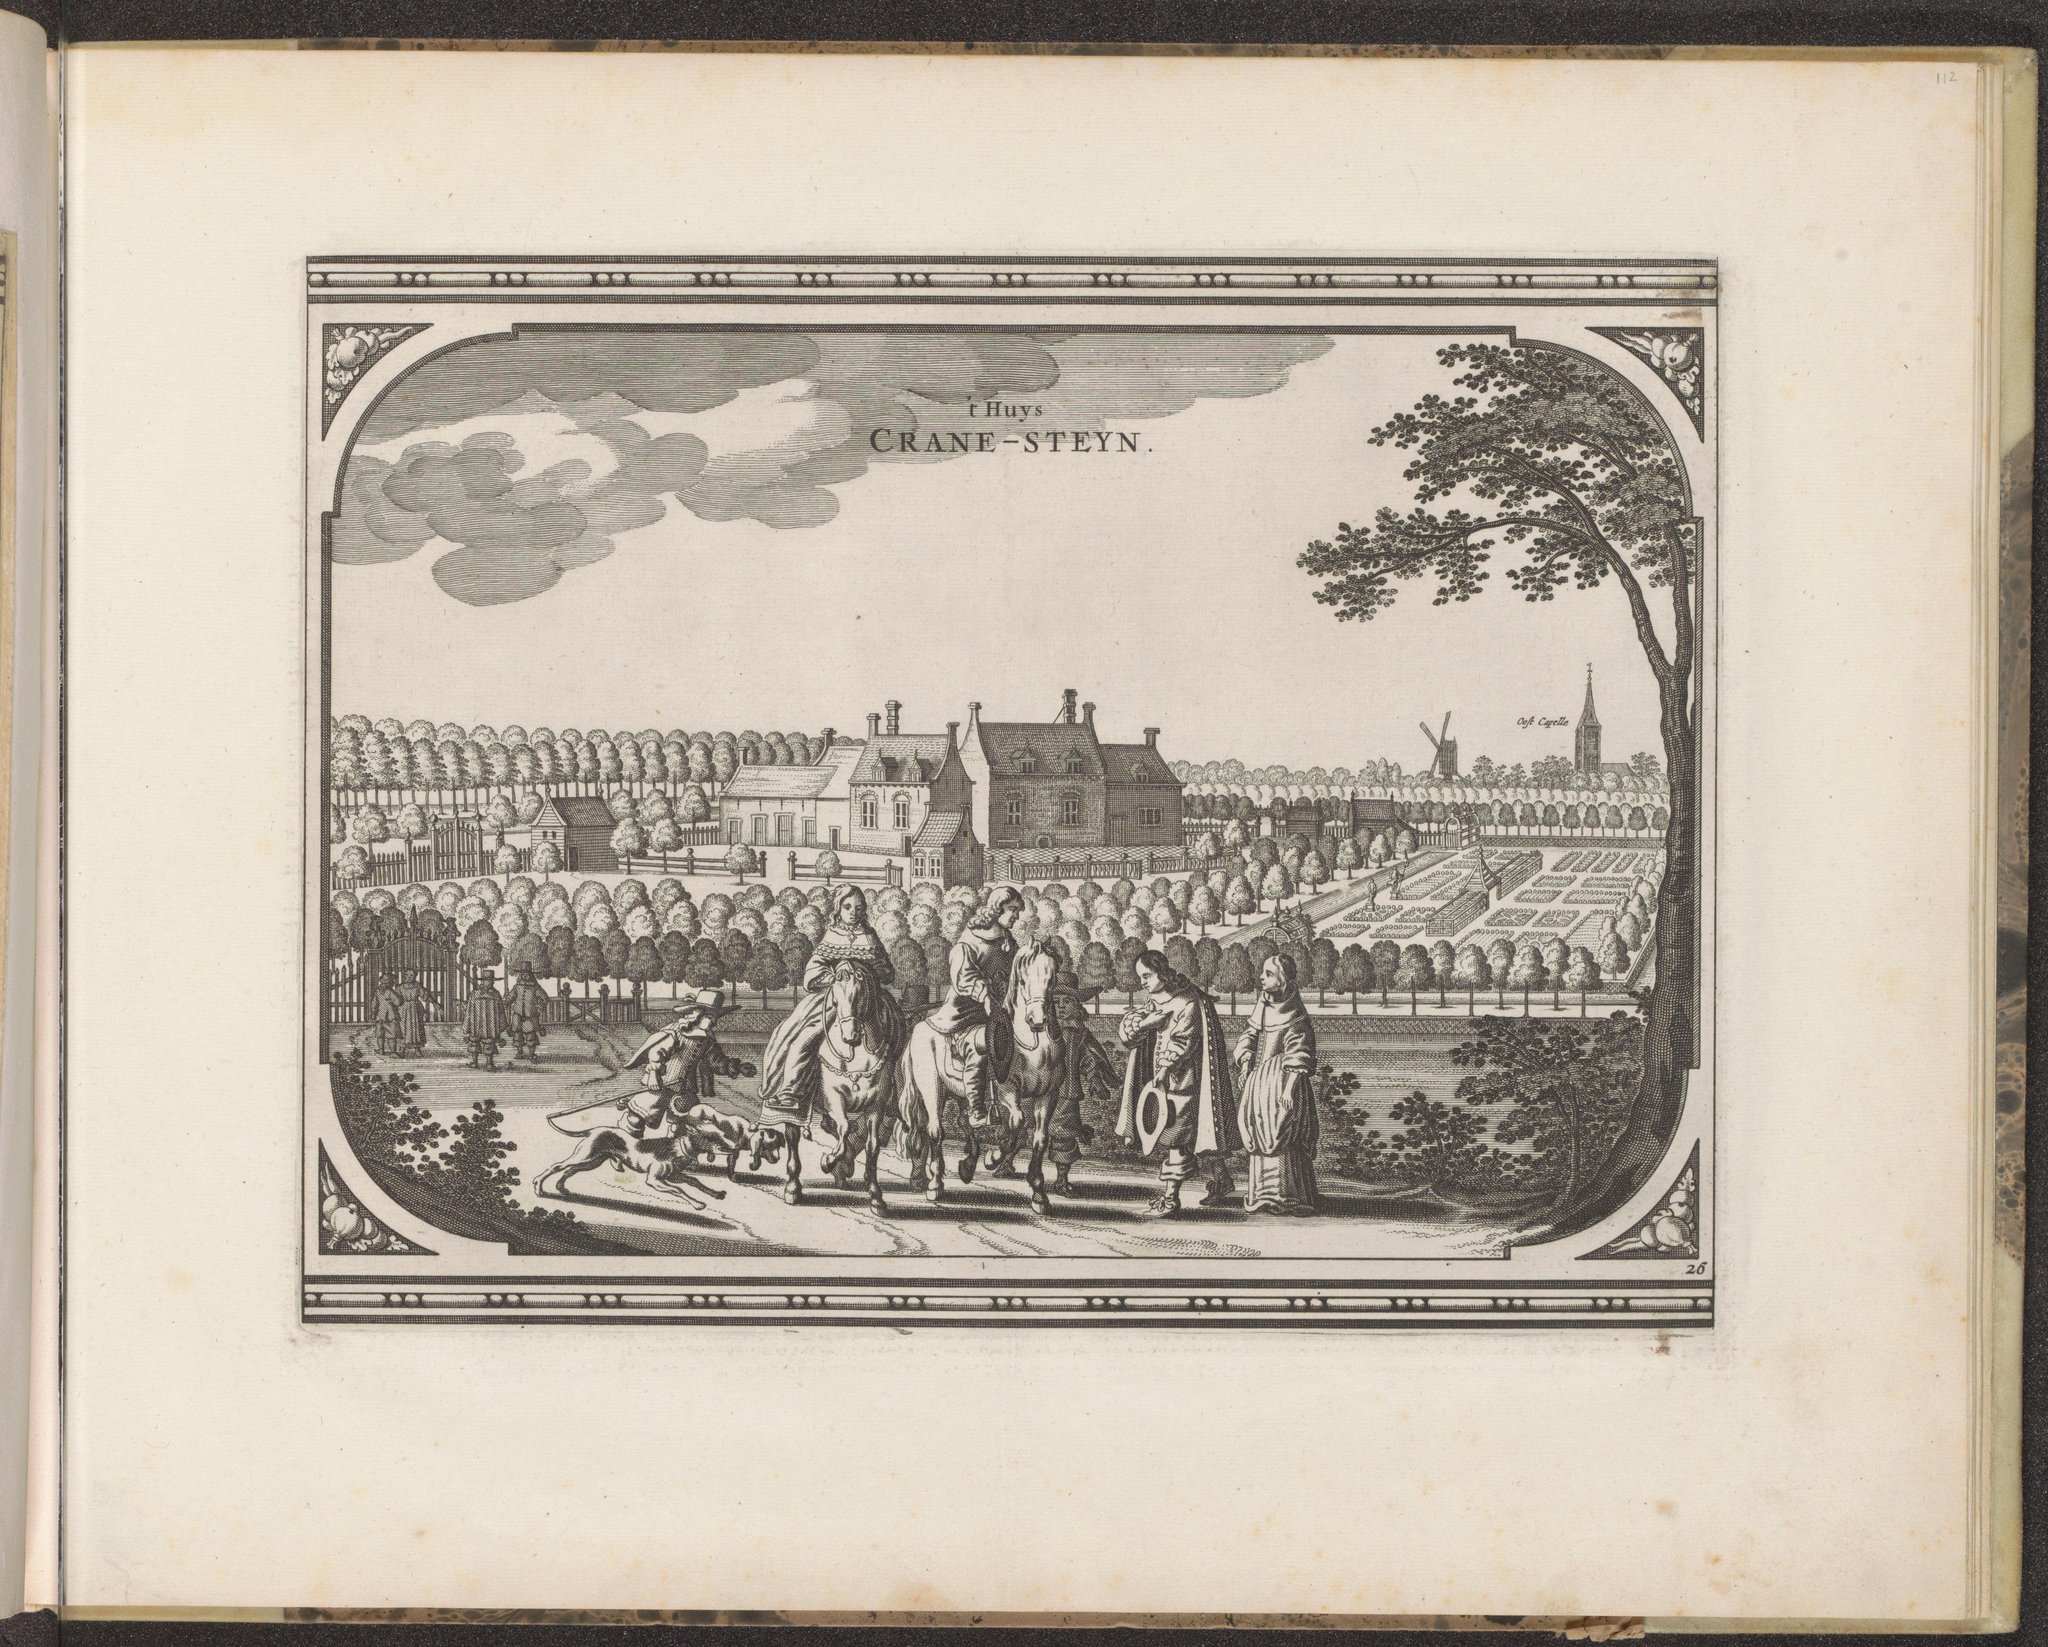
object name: album leaf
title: Gezicht op Huis Cranesteyn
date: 1662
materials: paper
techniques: etching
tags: riding a horse, ass, or mule; rider, horseman, city-view, and landscape with man-made constructions, baring the head, lifting one's hat, the rich, country-house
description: Gezicht op Huis Cranesteyn, een hofstede net ten zuidoosten van de dorpskern van Oostkapelle. Op de voorgrond worden een man en vrouw te paard begroet door een welgesteld paar. De man neemt zijn hoed af. De prent maakt deel uit van een album.